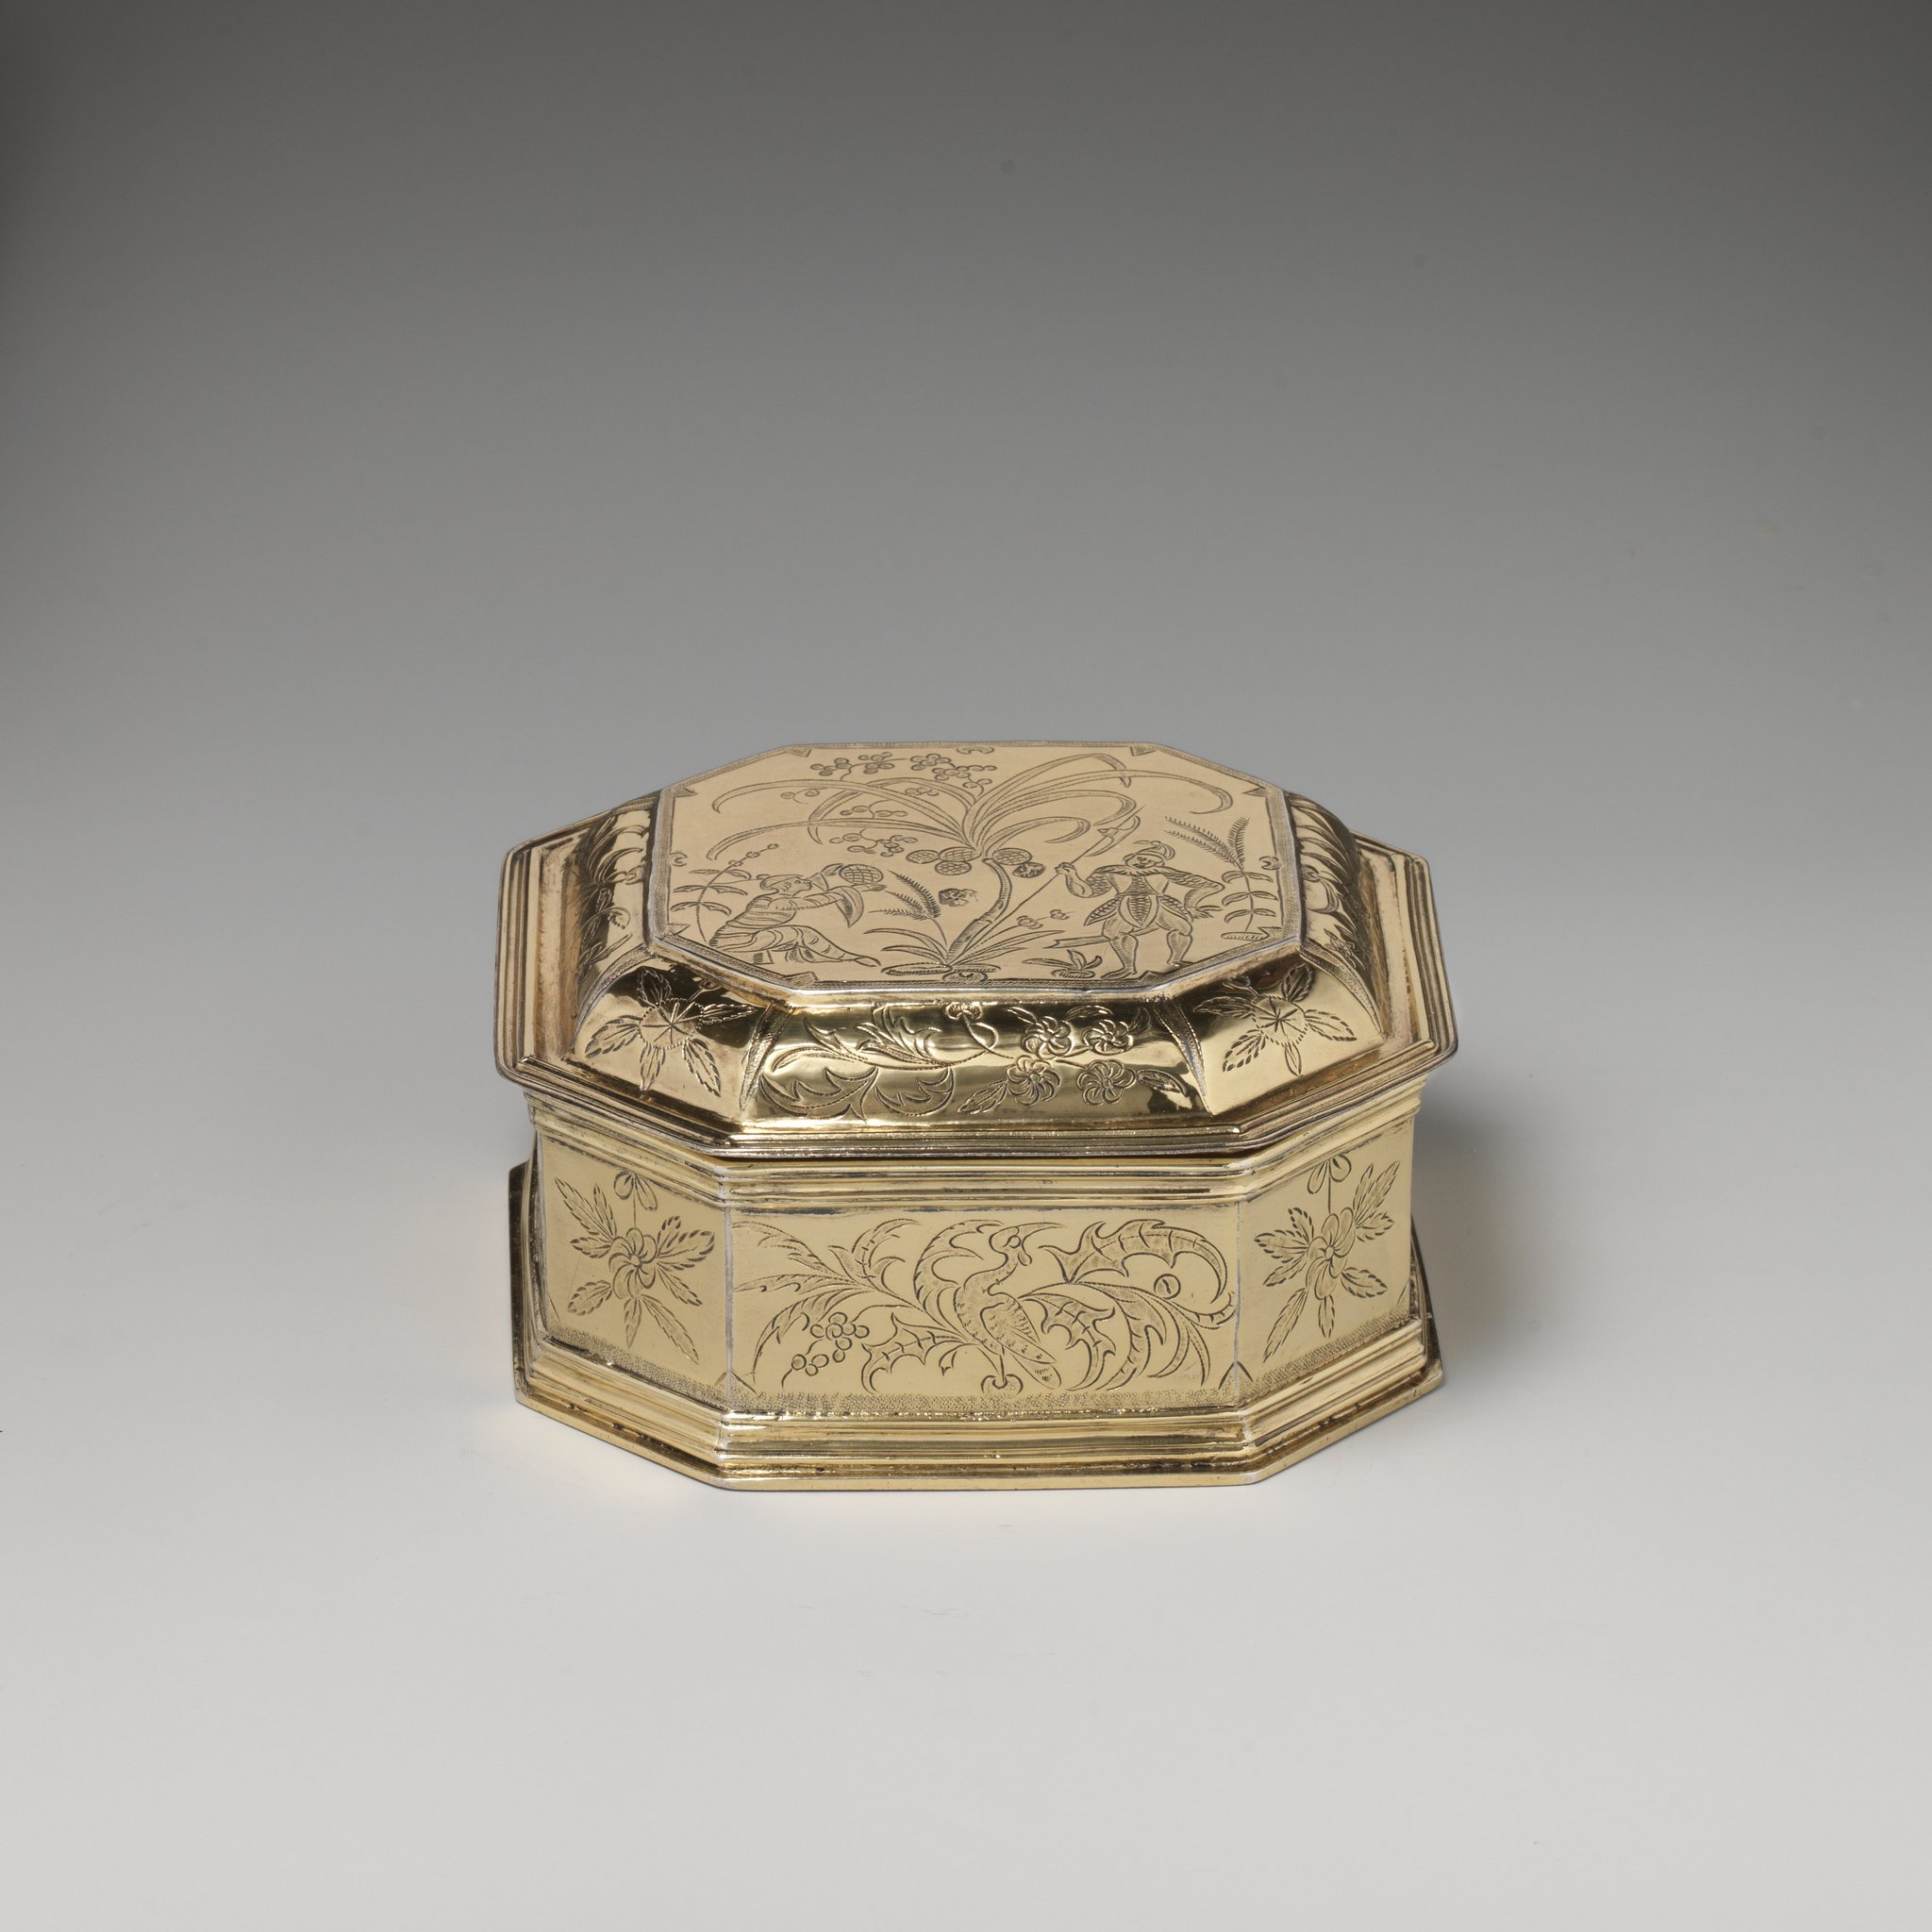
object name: box with cover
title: Box with cover (one of a pair) (part of a toilet service)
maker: william fowle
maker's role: maker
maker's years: 1658-1684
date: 1683-1684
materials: silver gilt